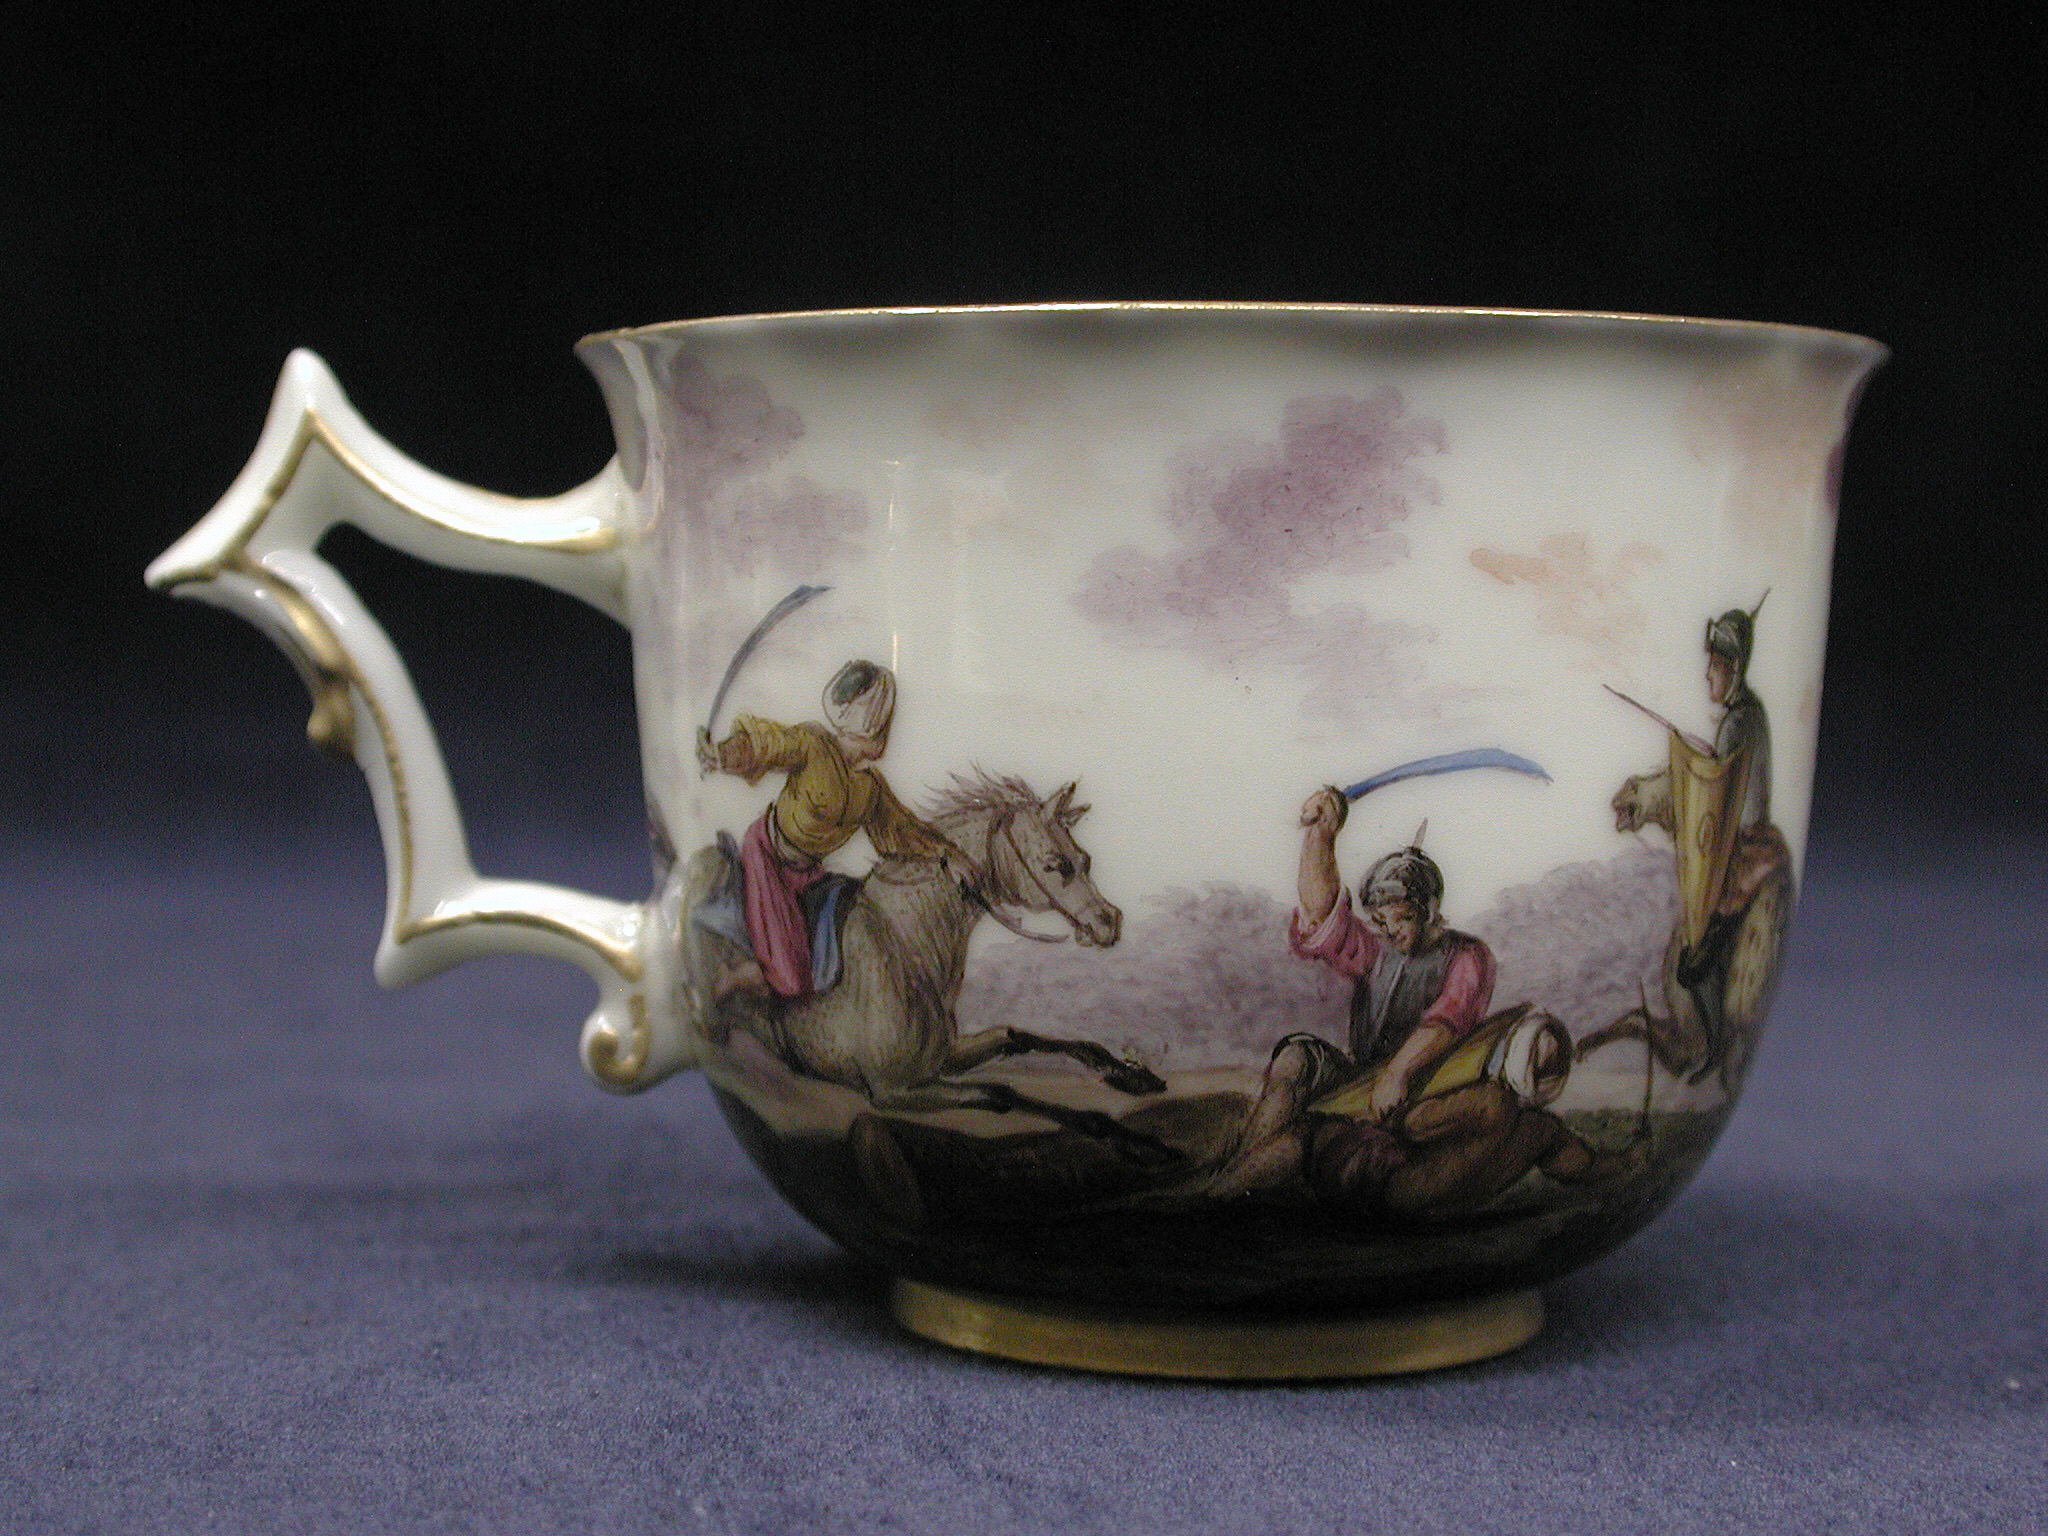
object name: cup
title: Cup (part of a service)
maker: capodimonte porcelain manufactory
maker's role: manufactory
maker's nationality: italian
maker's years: 1740-1759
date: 1743-1759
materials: soft paste porcelain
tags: swords,men,horses